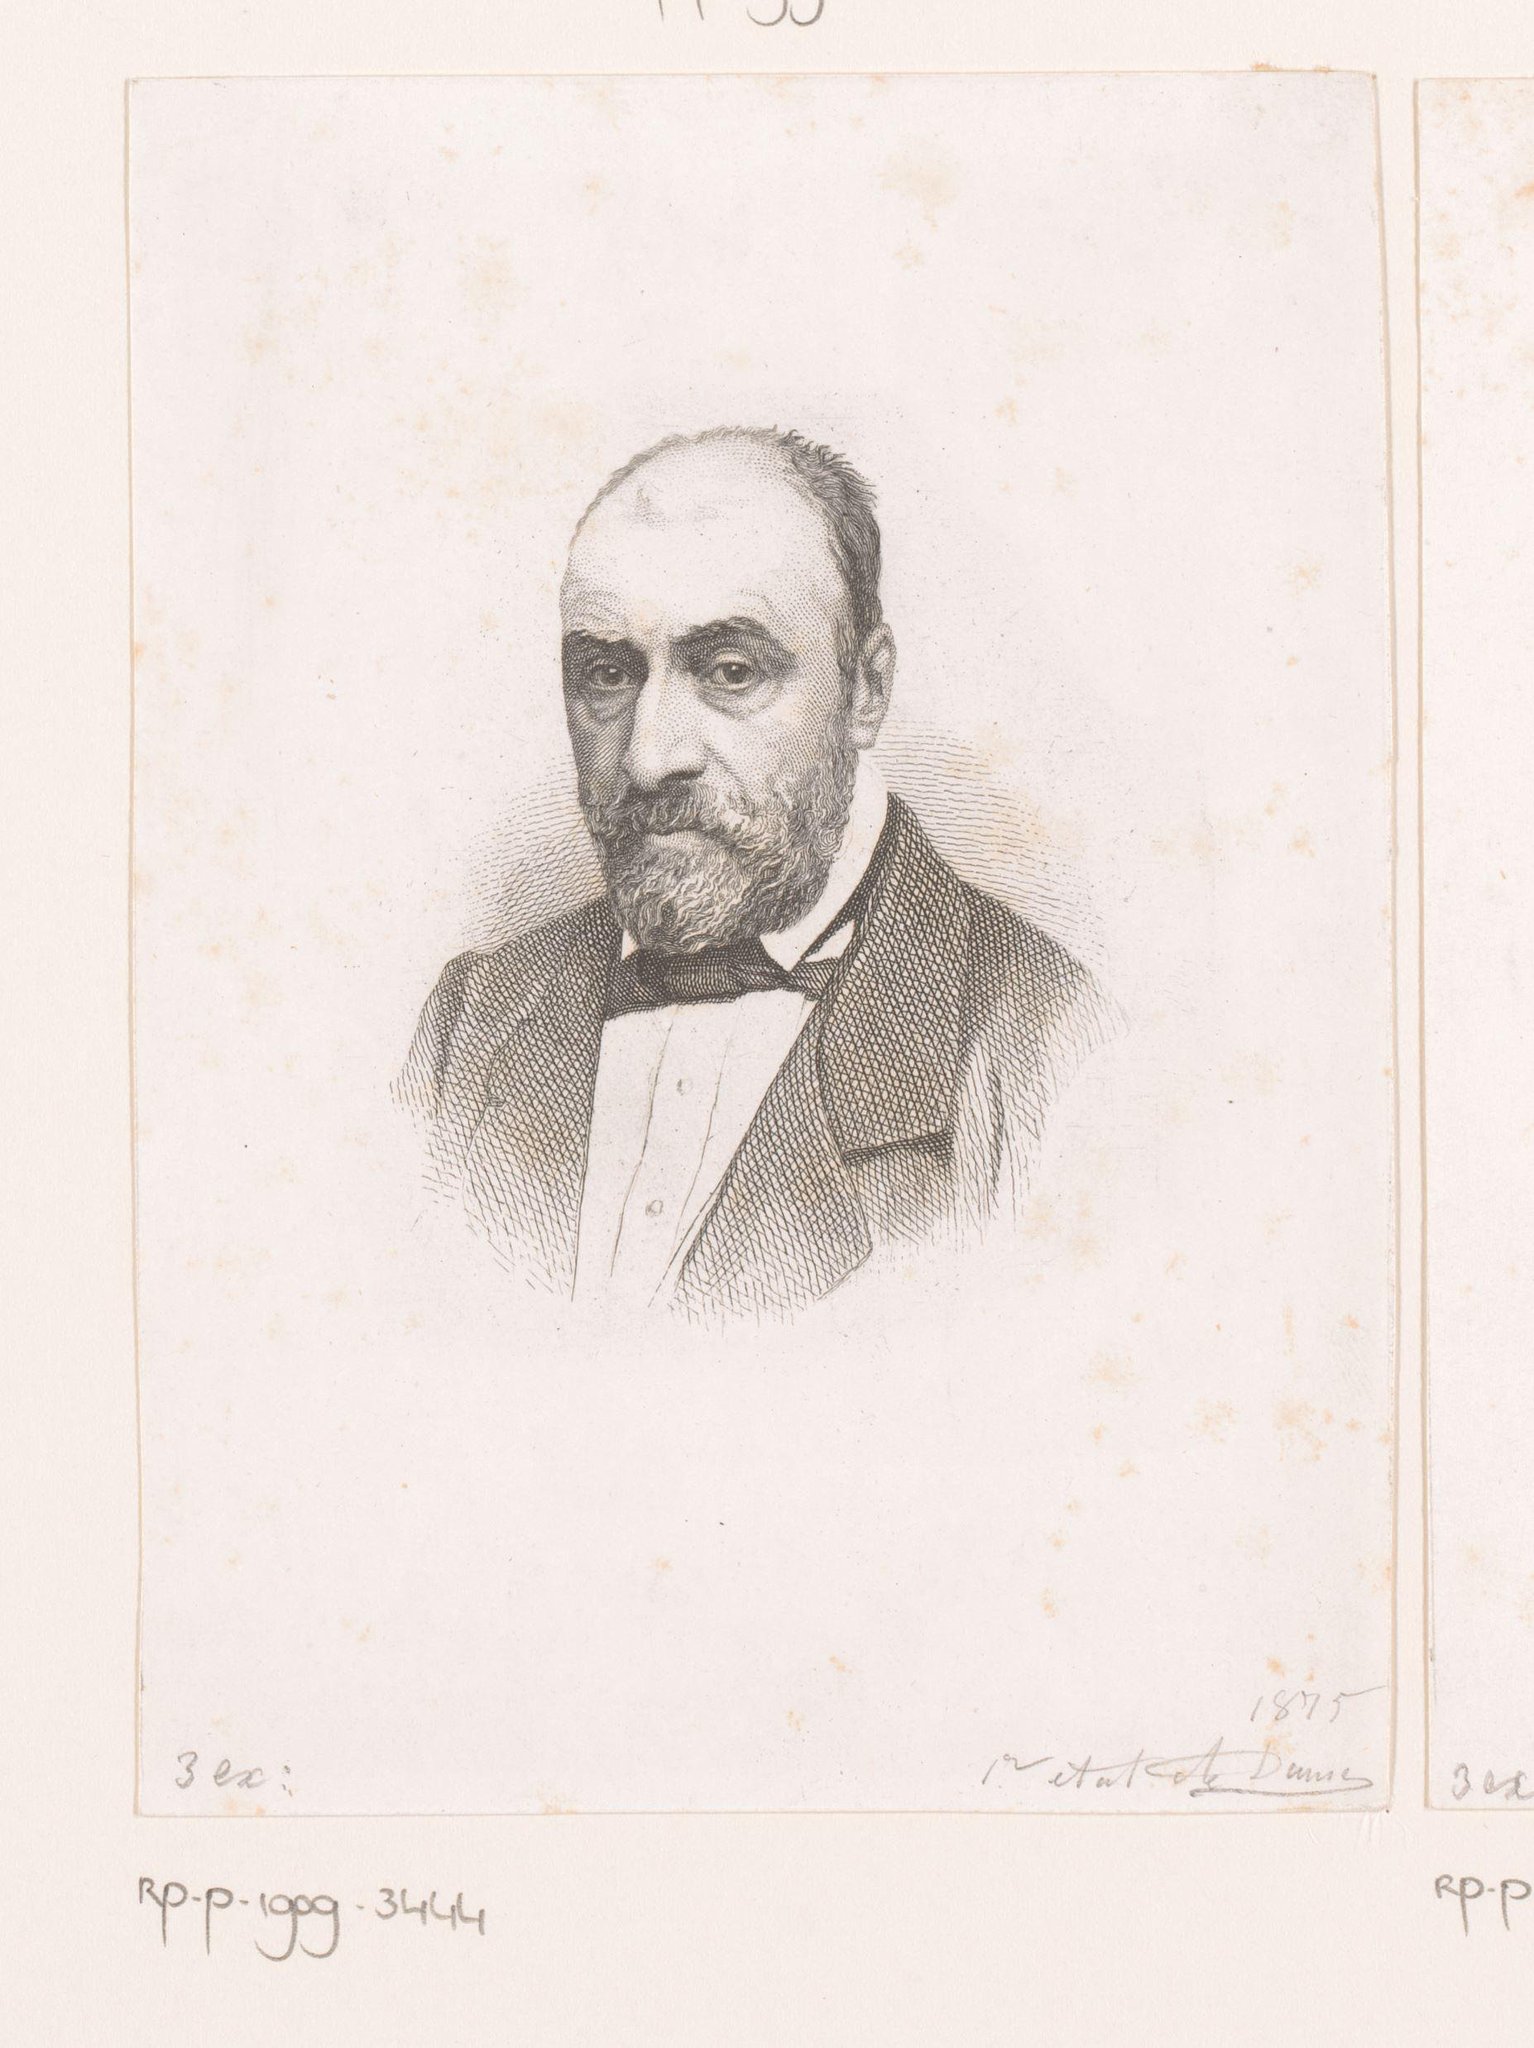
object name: print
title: Portret van Charles Bosselet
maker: auguste danse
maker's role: print maker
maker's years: 1829-1929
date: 1875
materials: paper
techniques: etching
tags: lyon, historical person (...) - historical person (...) portrayed alone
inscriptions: annotation: ‘3 ex; 1er etat de Danse’, collector's mark: Lugt 2228